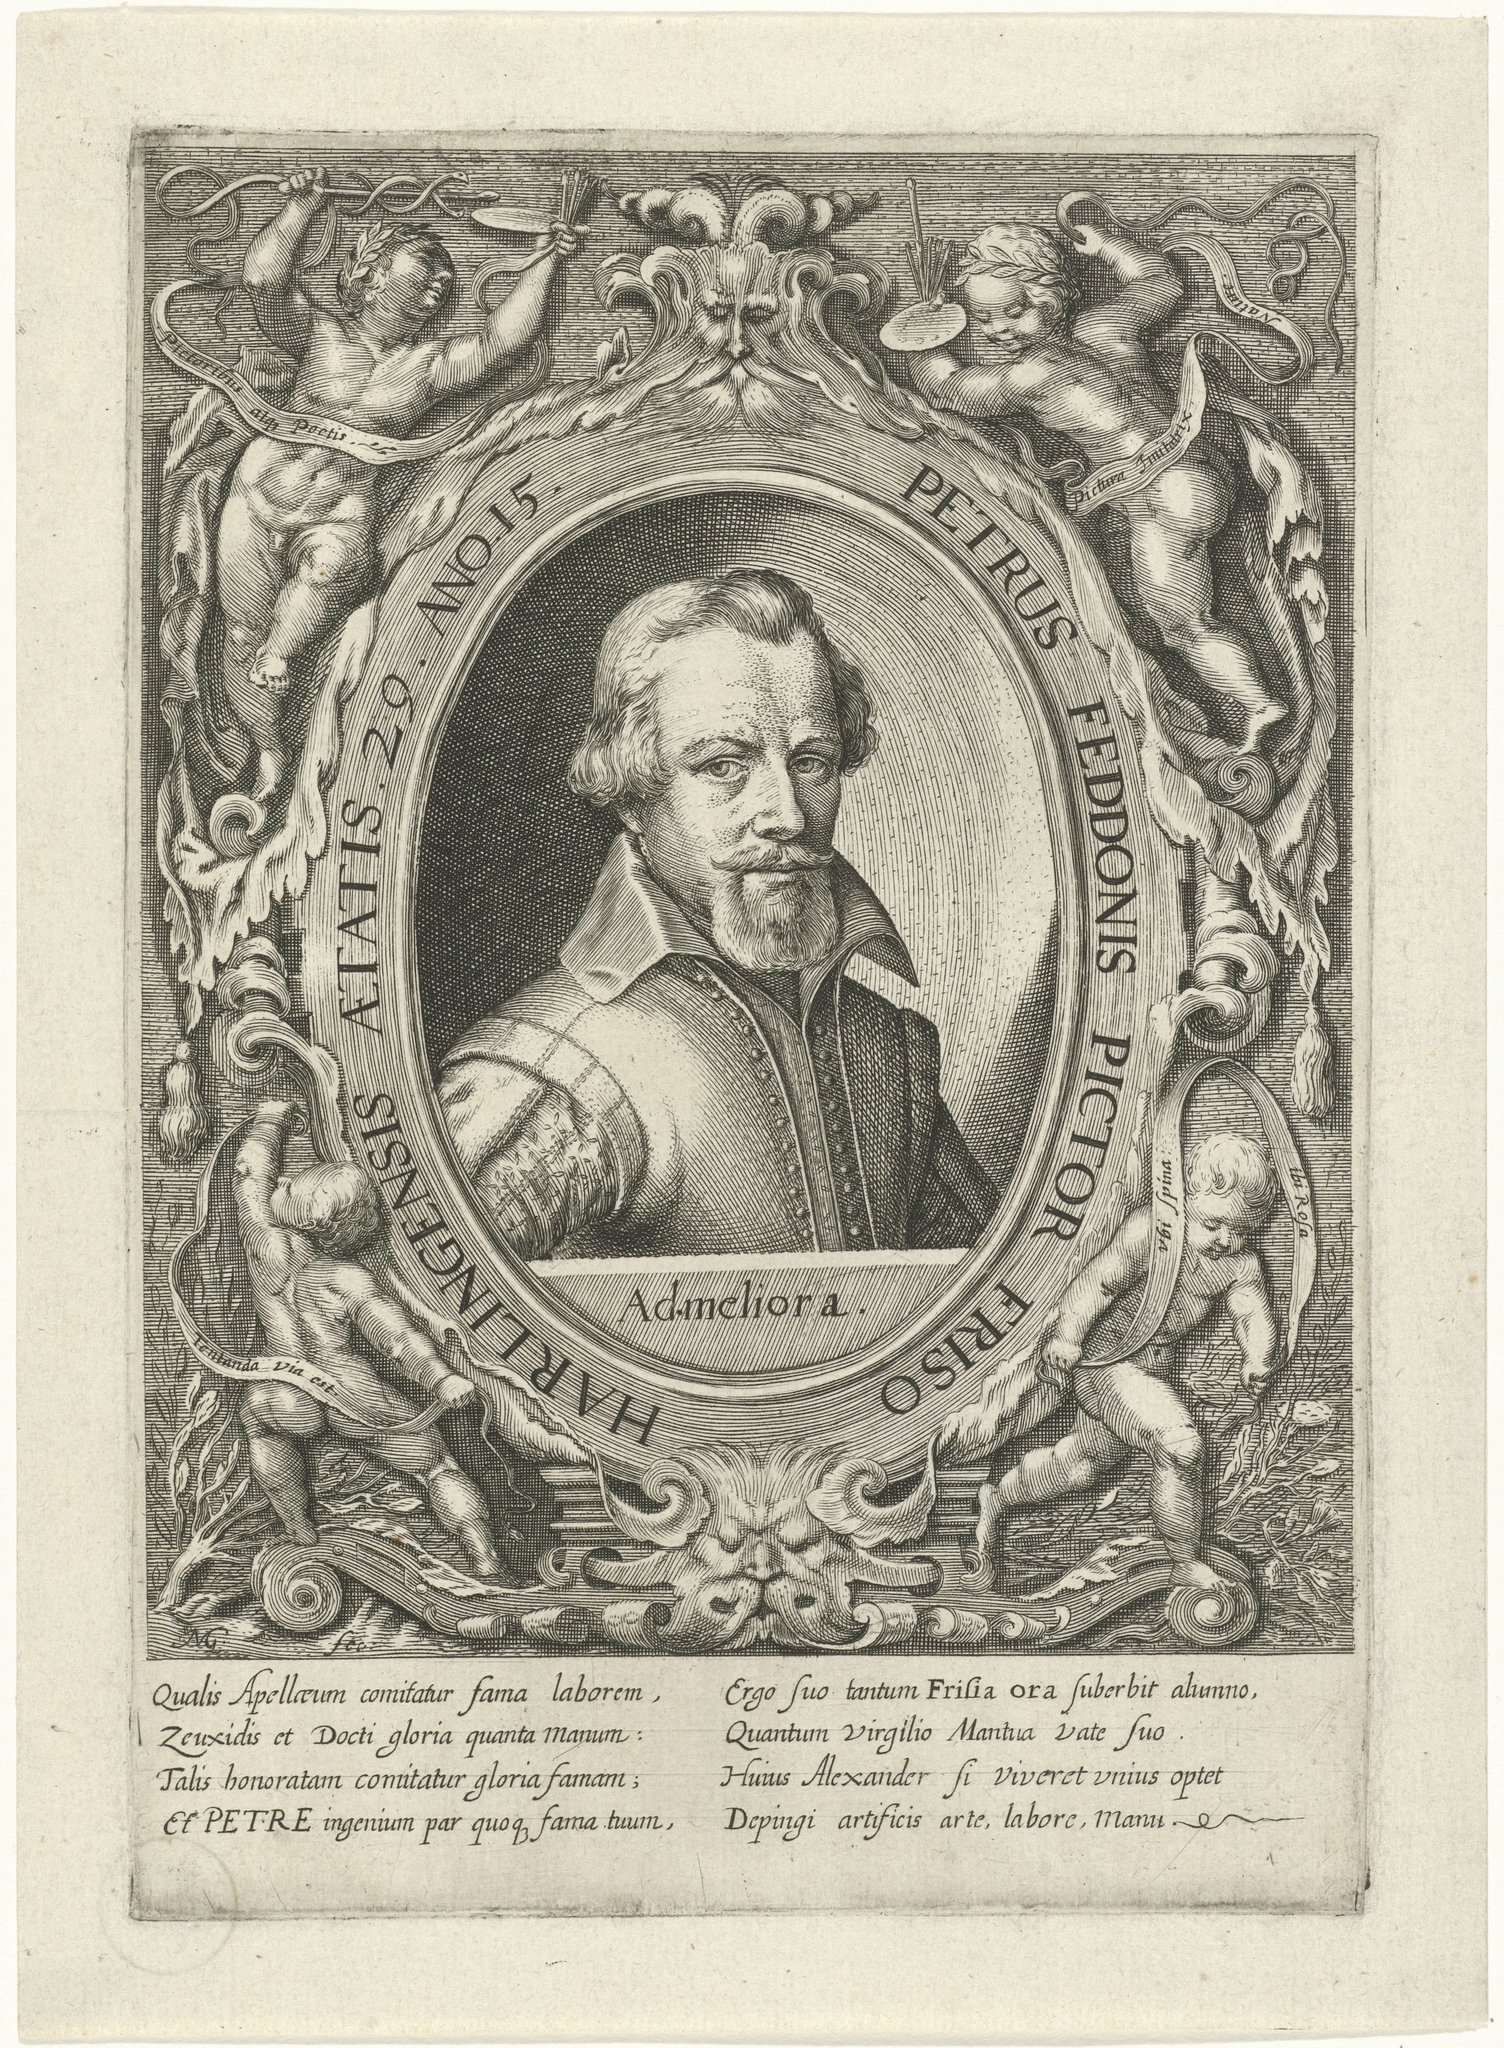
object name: print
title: Portret van Pieter Feddes van Harlingen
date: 1615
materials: paper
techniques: engraving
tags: harlingen, painter, print maker, publisher, pieter feddes van harlingen, portrait, self-portrait of painter, palette, caduceus (staff with two snakes, attribute of mercury), cupids: 'amores', 'amoretti', 'putti'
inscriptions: collector's mark: Lugt 2228, collector's mark: Lugt 514, collector's mark: Lugt 2227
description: Portret in ovale lijst van Pieter Feddes van Harlingen, schilder, prentmaker en uitgever. Buste naar rechts. Rondom het portret vier putti. Twee van de putti hebben schilderspaletten in de hand. De prent heeft een Latijns onderschrift.